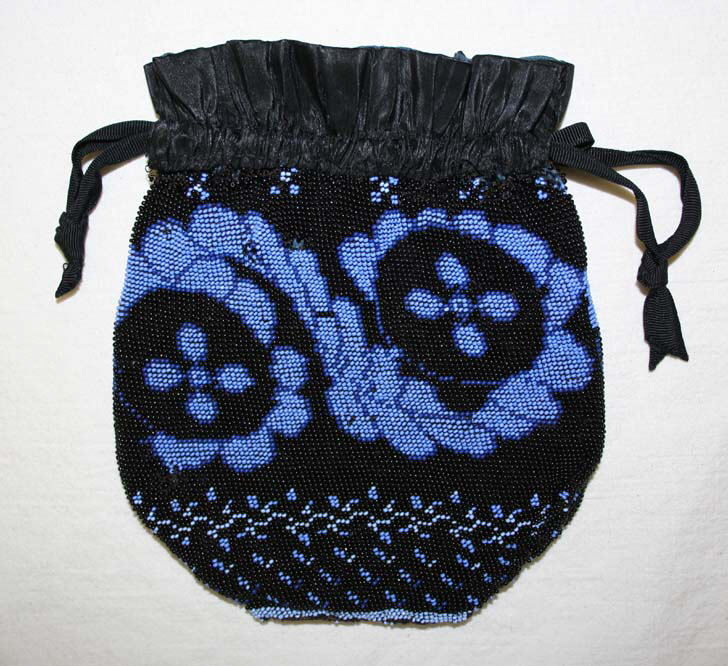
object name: drawstring bag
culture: american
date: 1840-1849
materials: glass, silk